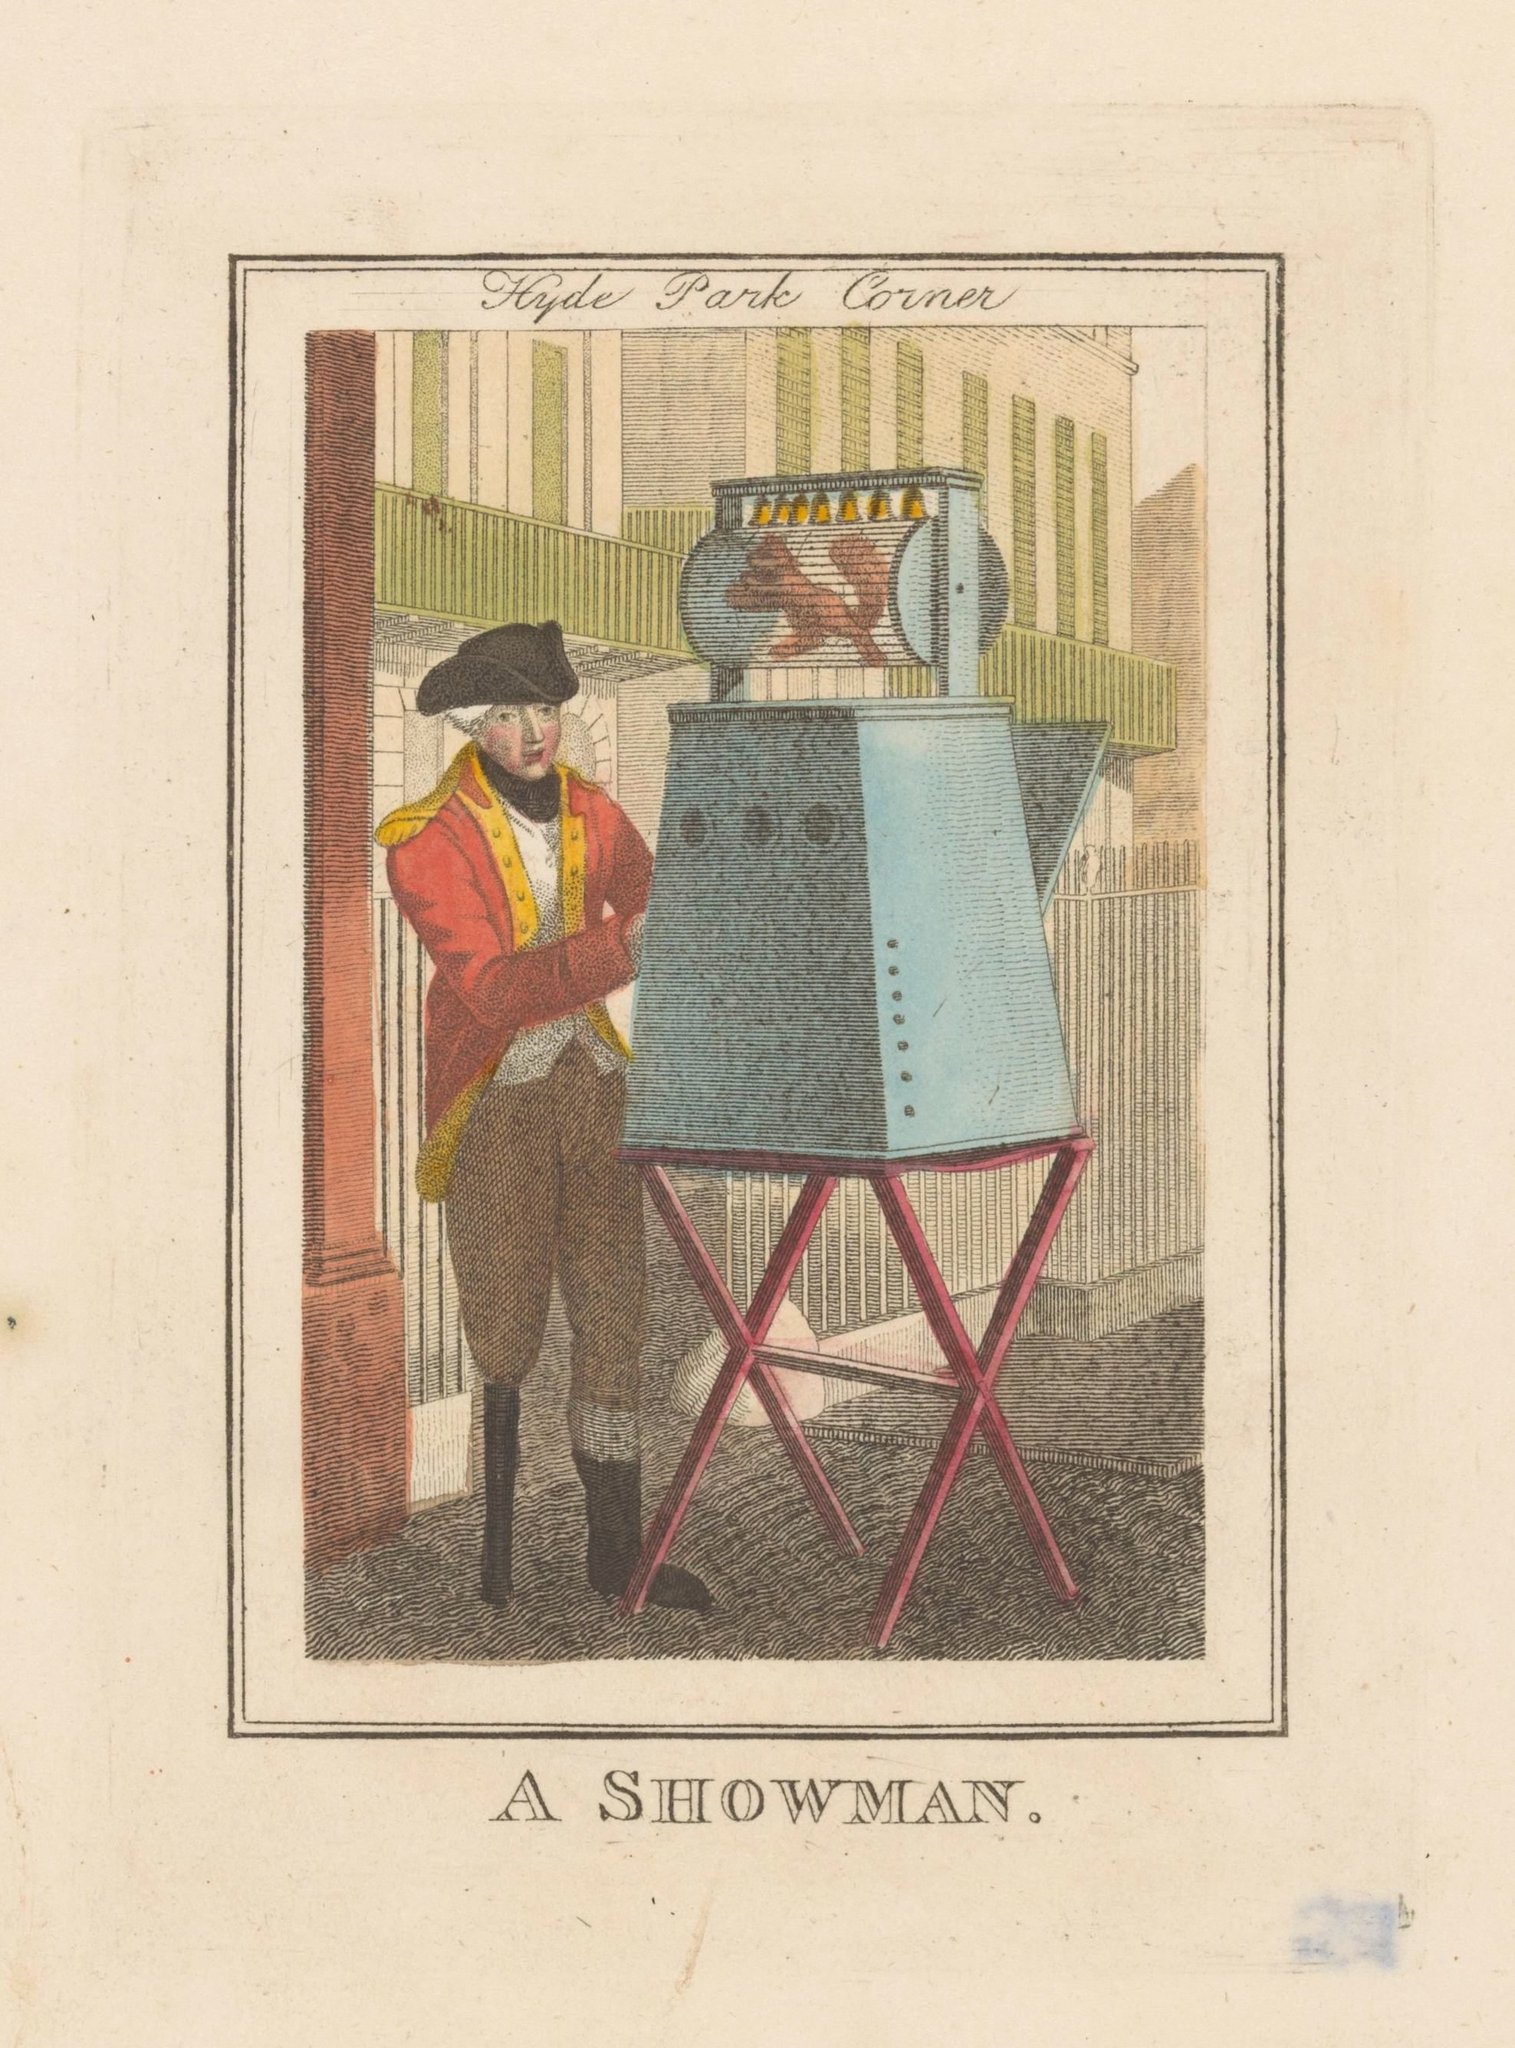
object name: print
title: A showman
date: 1804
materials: paper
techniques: etching, hand coloring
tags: performance in the open air (pleasure fair), peep-show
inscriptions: collector's mark: Lugt 2228, collector's mark: Lugt 4779, collector's mark: Lugt 4780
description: De eigenaar van de kast heeft een houten been en draagt een rode uniformjas en een driepuntige steek. Bovenop de kast een eekhoorn in een tredmolen met belletjes.